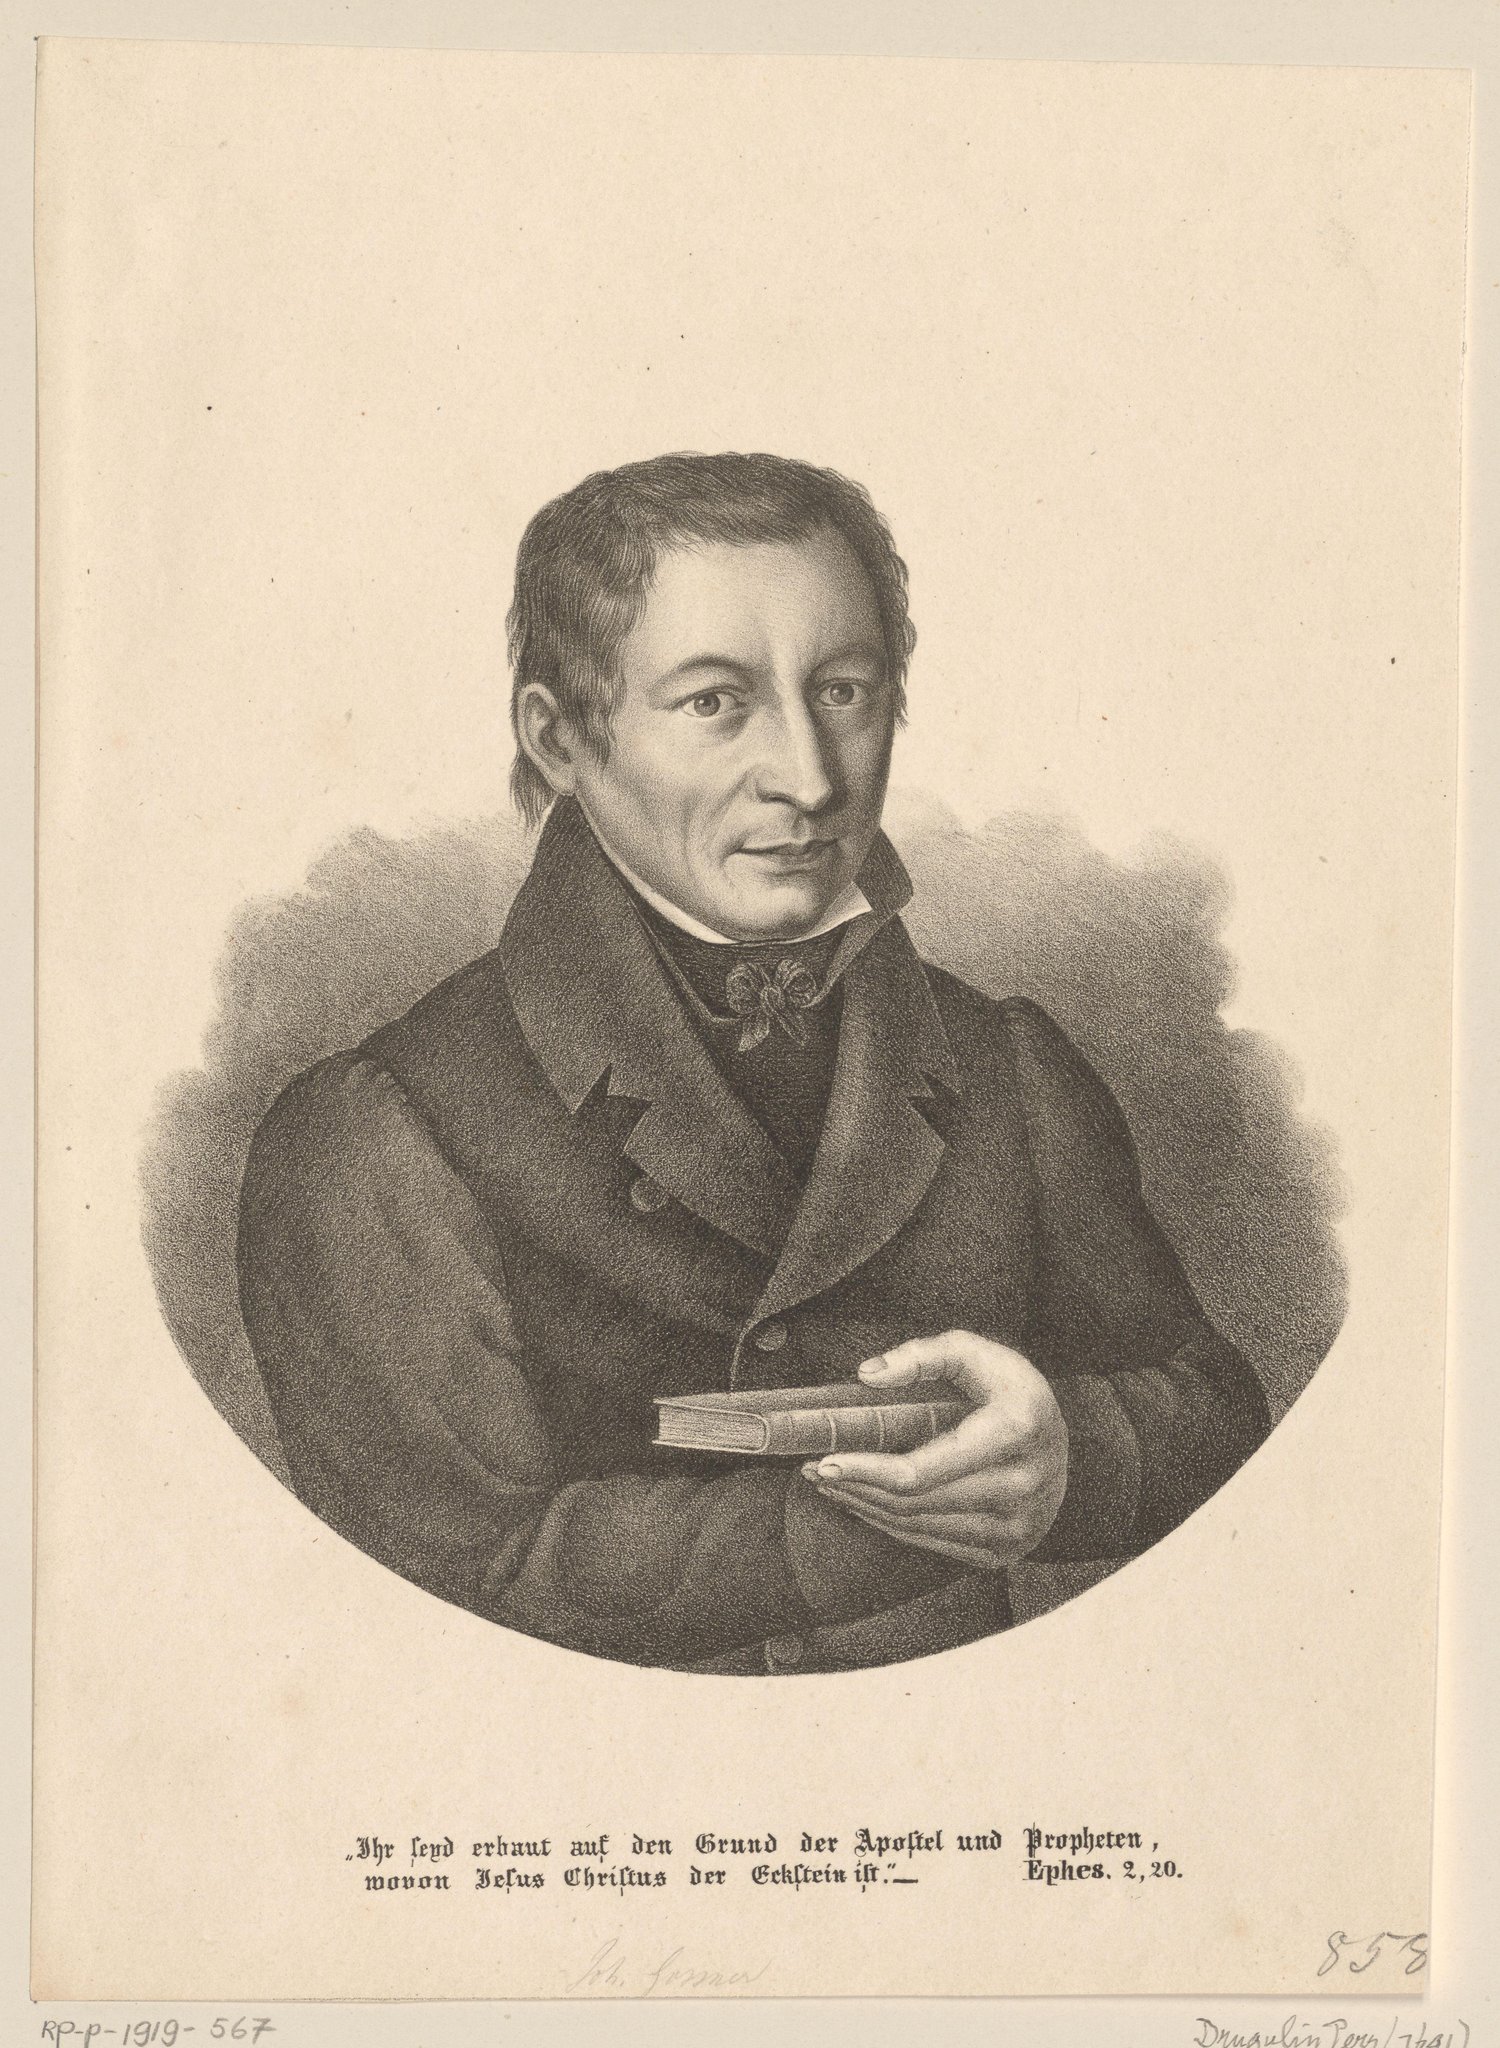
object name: print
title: Portret van Johann Gossner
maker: Anonymous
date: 1800-1900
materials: paper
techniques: lithograph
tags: berlin, clergyman, theologian, historical persons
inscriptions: collector's mark: Lugt 2228